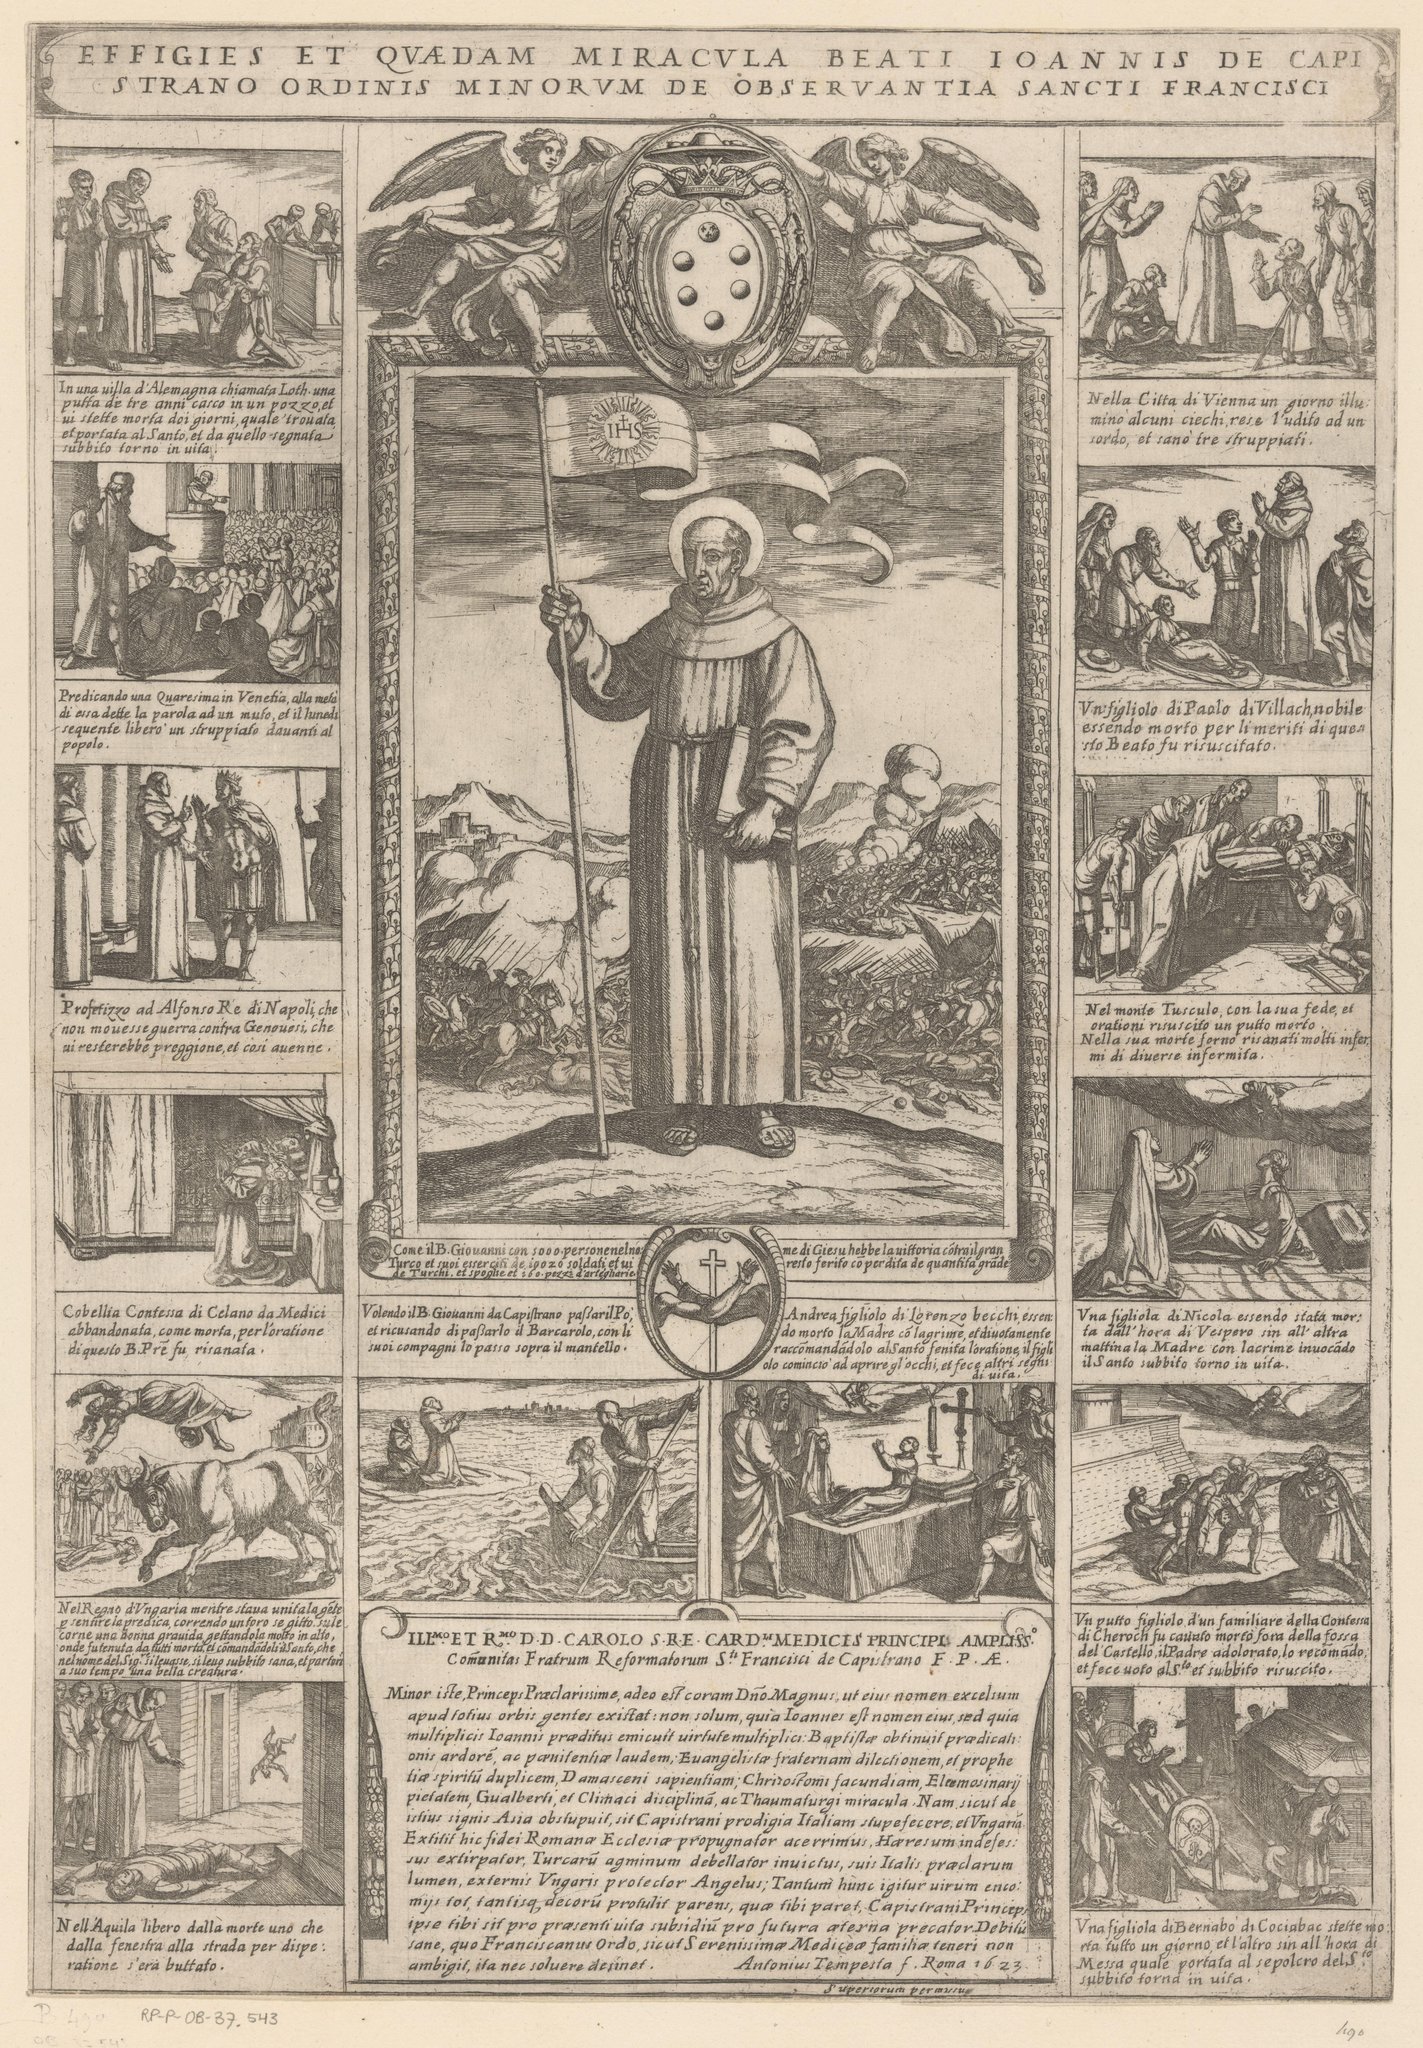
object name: print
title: Effigies et quaedam miracula beati Ioannis de Capistrano ordinis minorum de observantia sancti Francisci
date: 1623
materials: paper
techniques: etching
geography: italy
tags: saints, battle, monk(s), friar(s)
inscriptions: collector's mark: Lugt 240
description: Centraal de franciscaner monnik Johannes Capistranus met boek en banier met IHS monogram. Op de achtergrond strijden christenen tegen de Turken. Rondom een rand met veertien voorstellingen uit het leven van H. Johannes Capistranus met telkens een onderschrift in het Italiaans. Onder een cartouche met opdracht in het Latijn. Boven het wapen van kardinaal Carlo de'Medici.